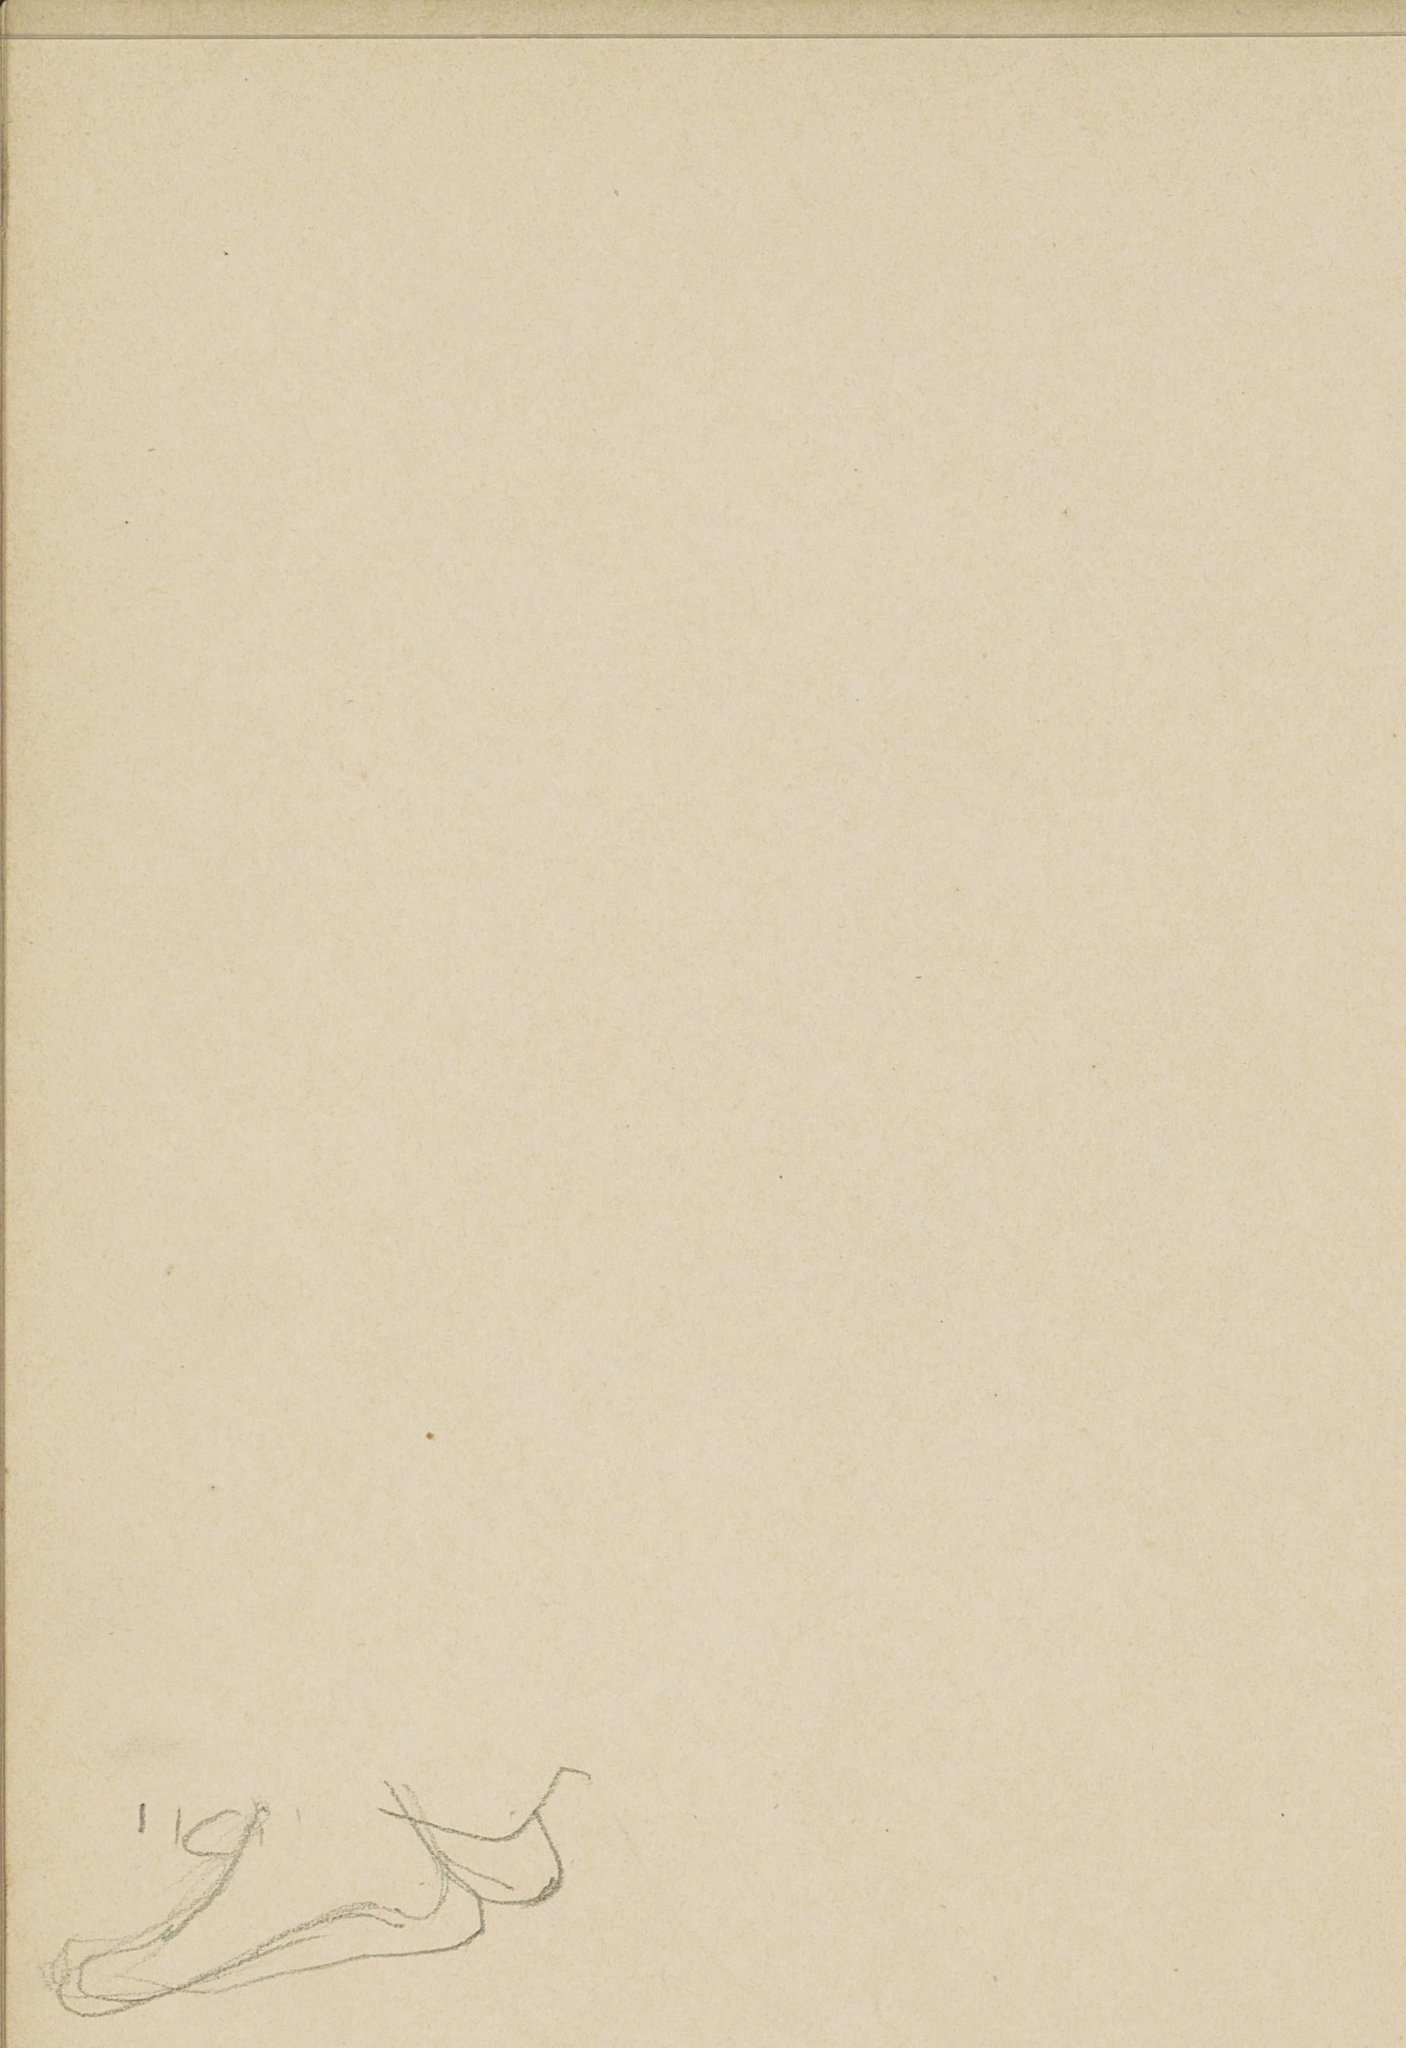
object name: sketchbook leaf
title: Blote voeten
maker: antoon derkinderen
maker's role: draughtsman, painter, print maker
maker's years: 1859-1925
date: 1889-1894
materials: paper, pencil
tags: foot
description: Blad 14 verso uit een schetsboek met 33 bladen.